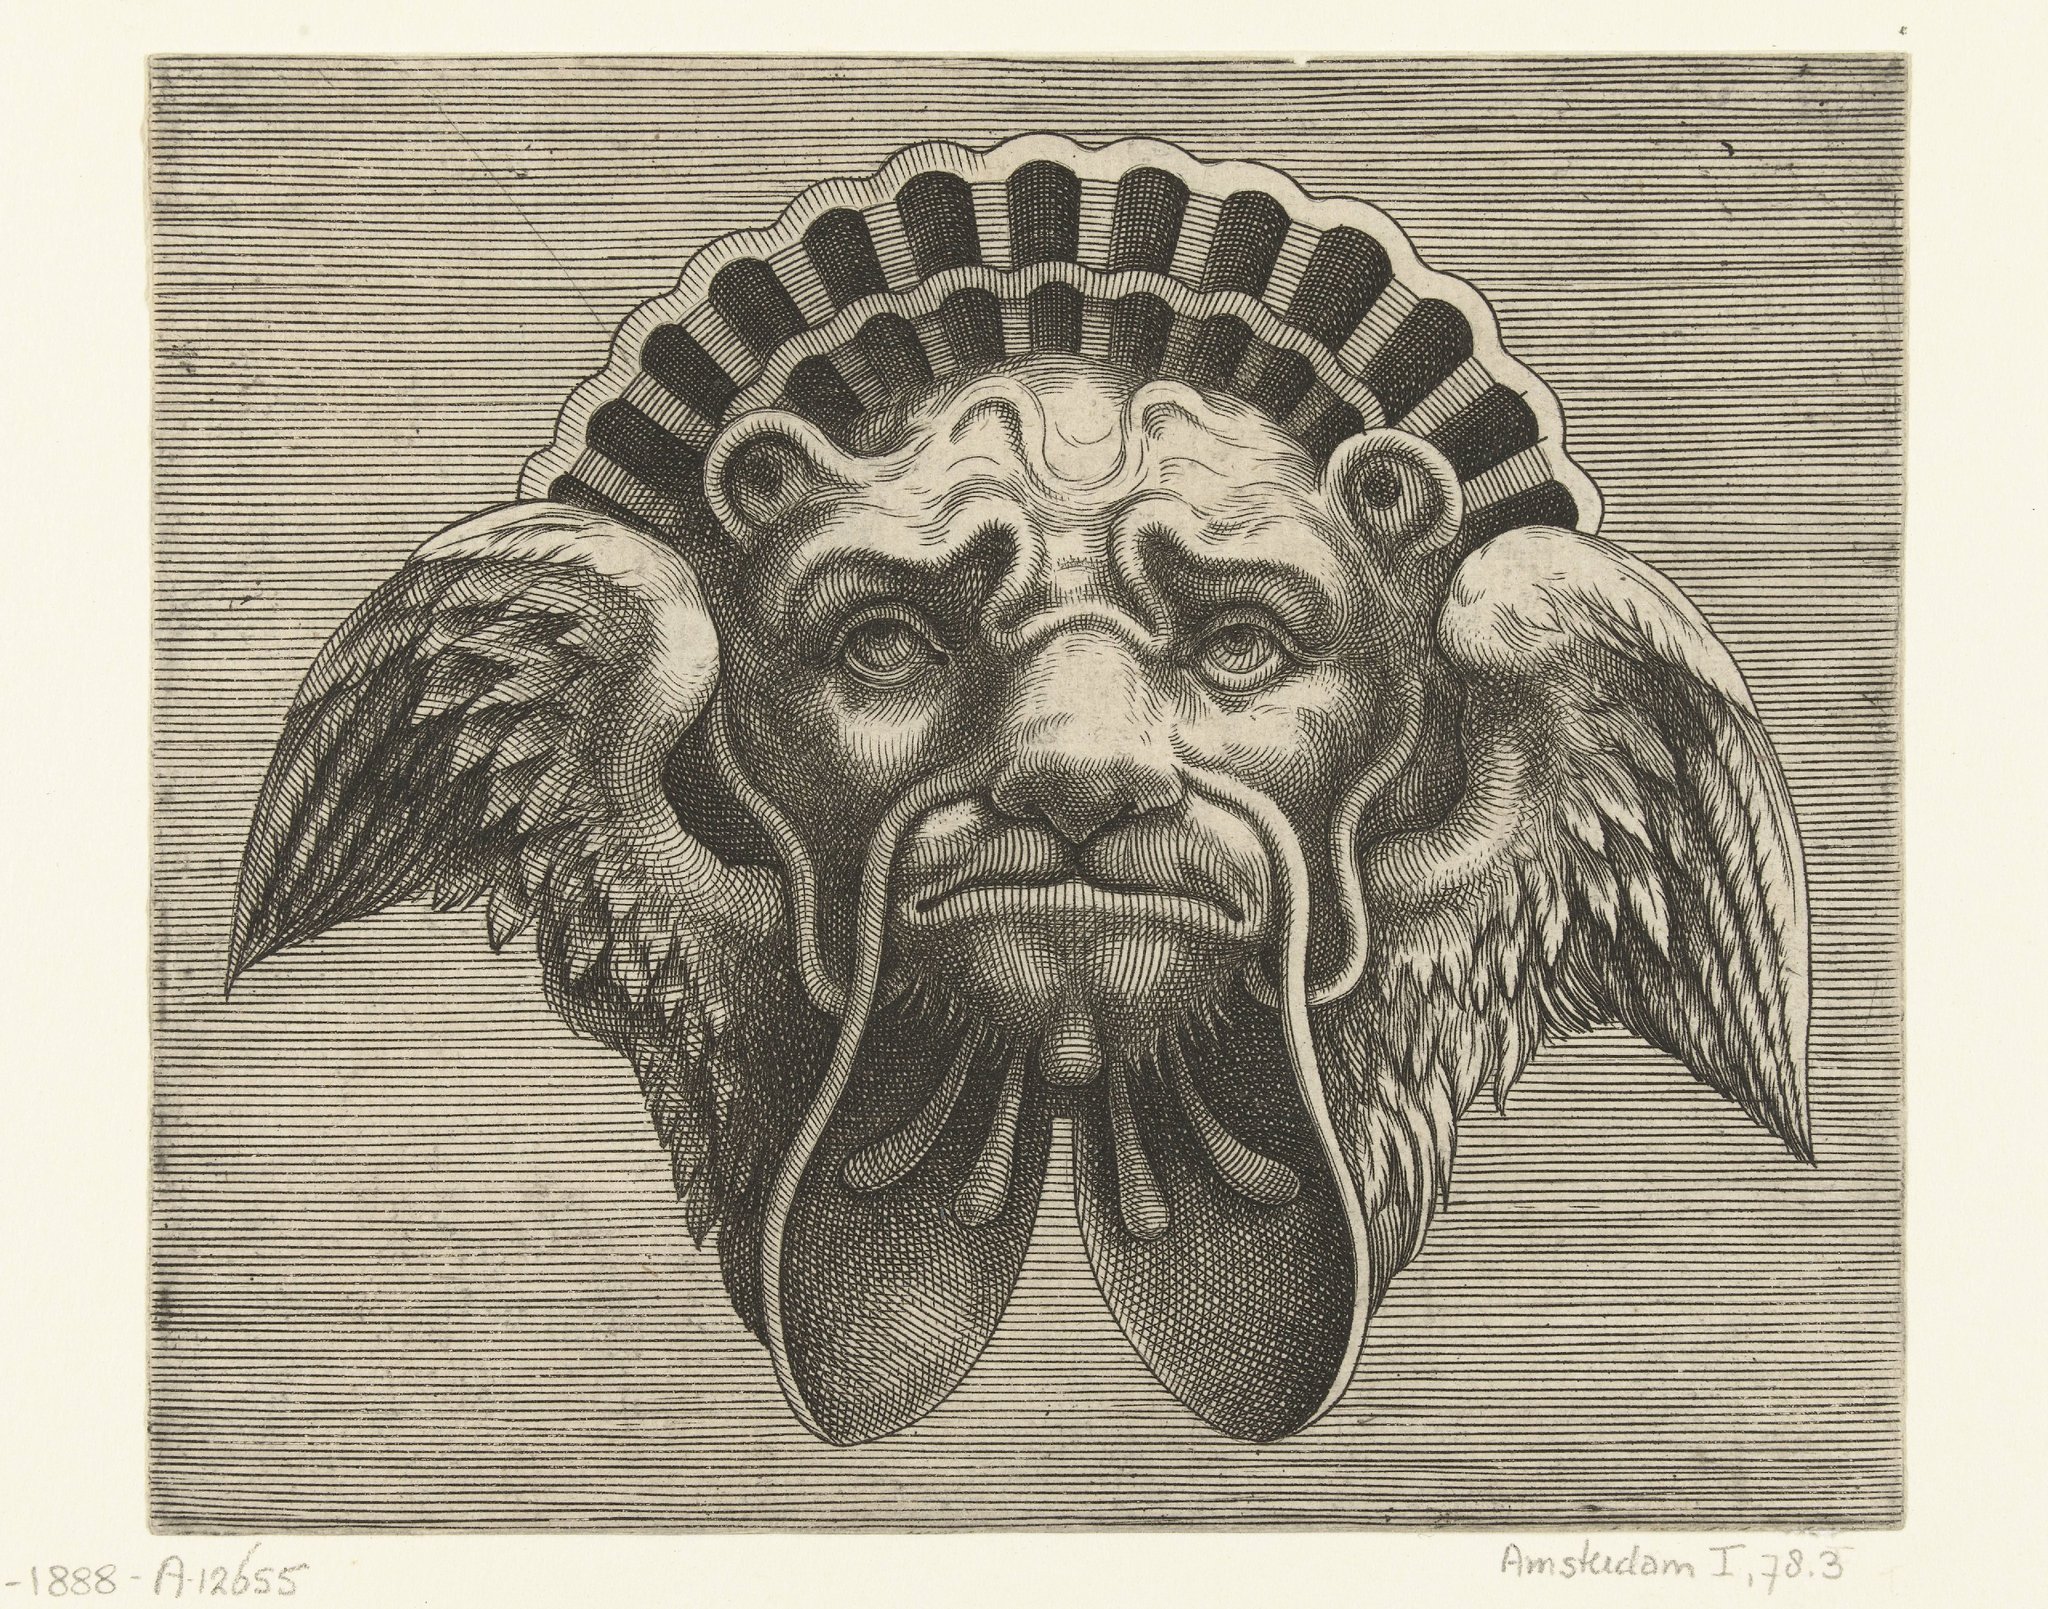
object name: print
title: Pourtraicture ingenieuse de plusieurs facons de masques…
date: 1555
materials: paper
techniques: engraving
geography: antwerp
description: Een van 14 bladen uit een serie van 18 met als titel 'Pourtraicture ingenieuse de plusieurs façons de masques...'. Het titelblad ontbreekt.